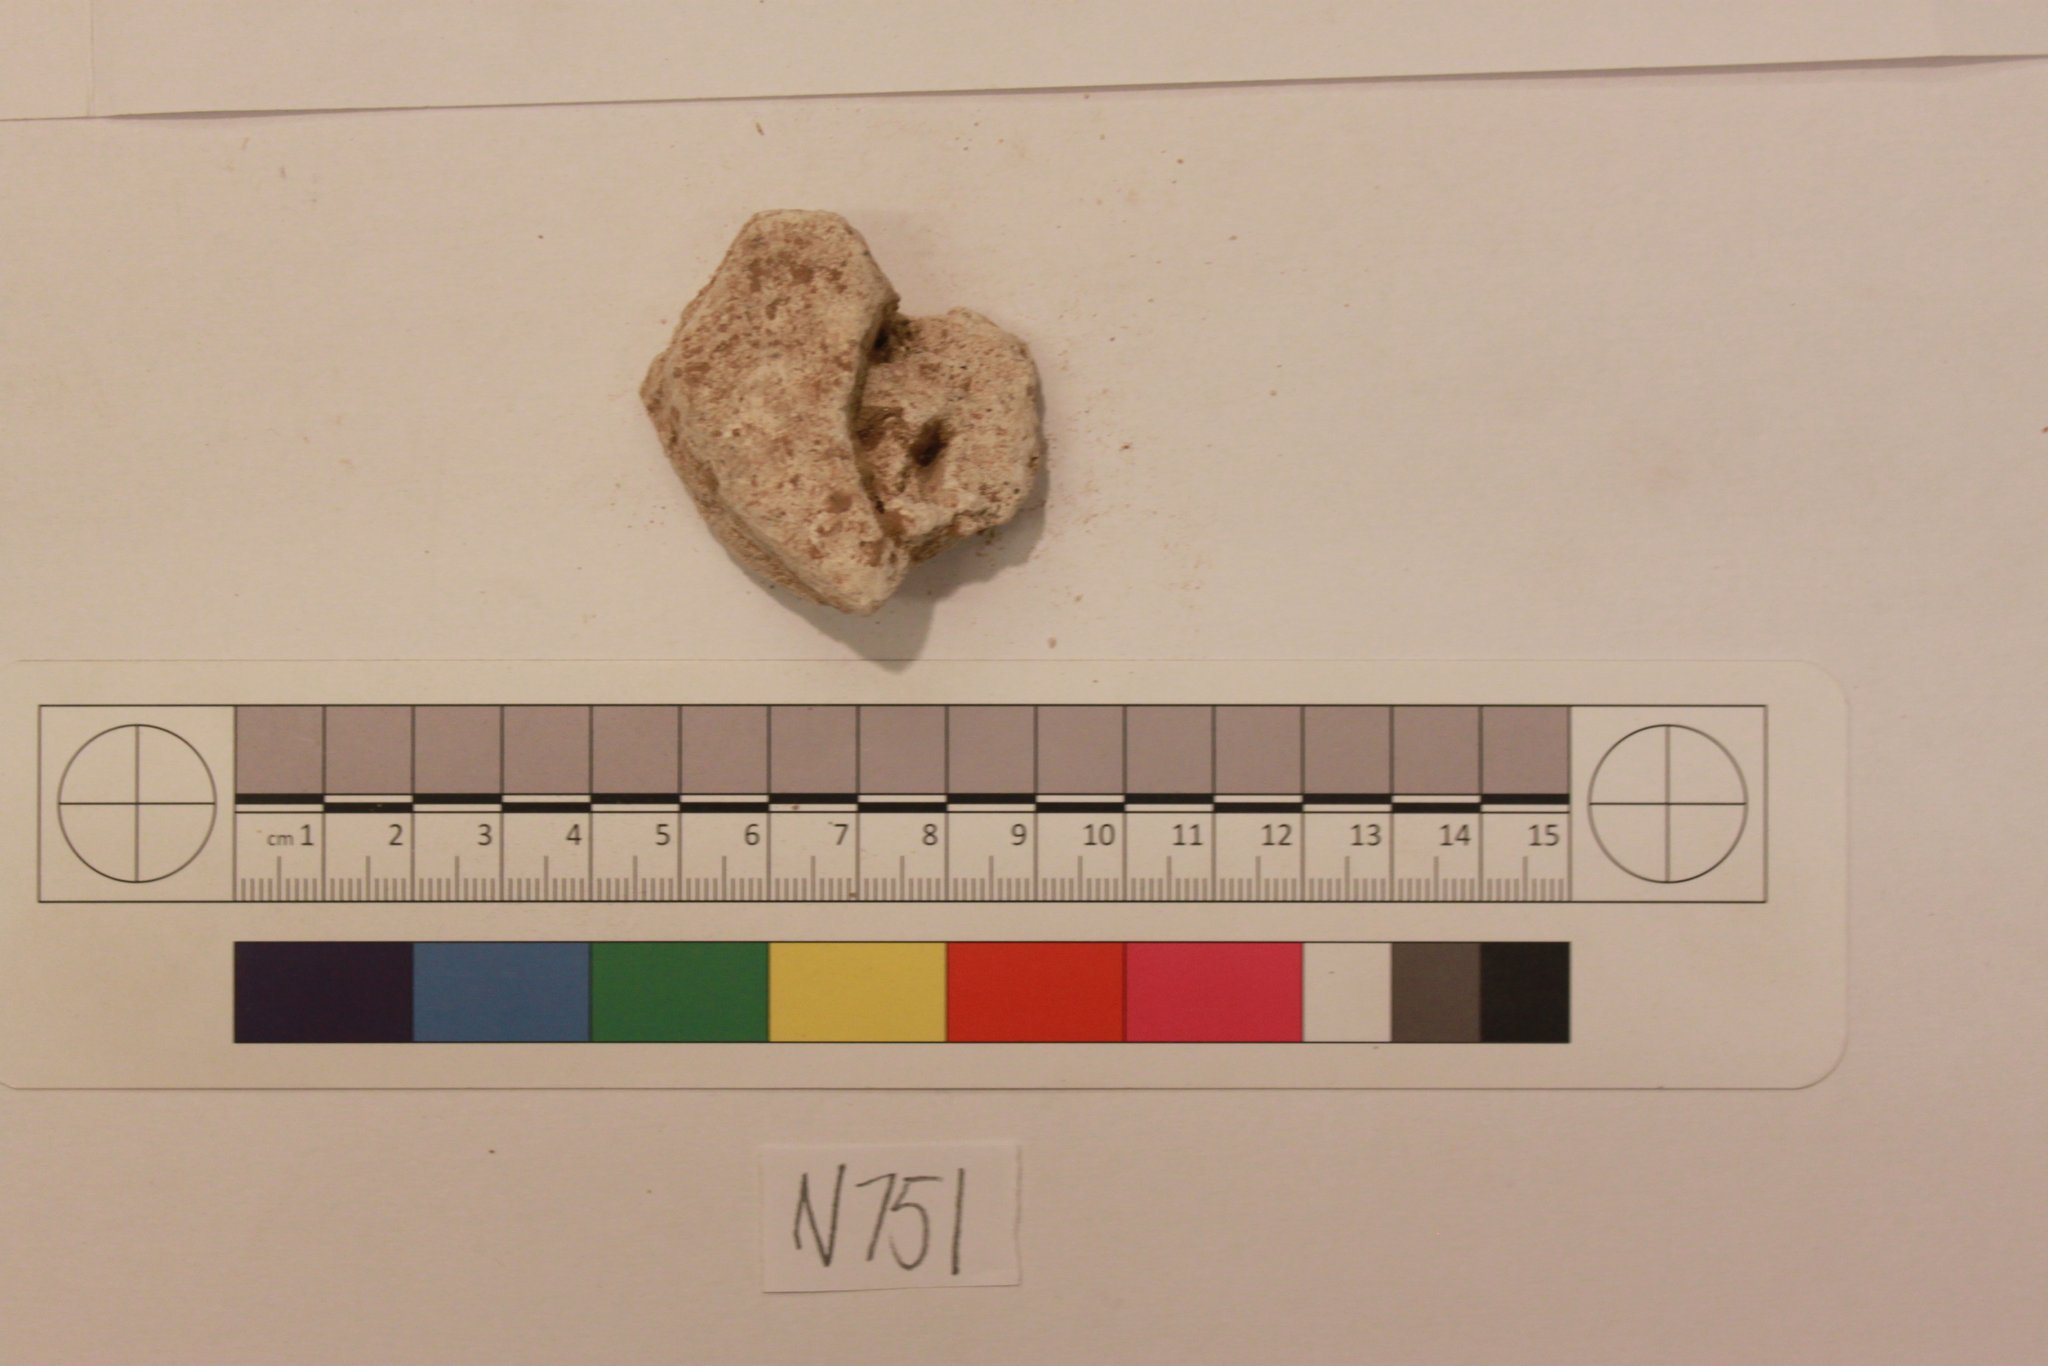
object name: fragment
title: Stucco Fragment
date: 701-1200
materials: plaster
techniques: carving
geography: iran